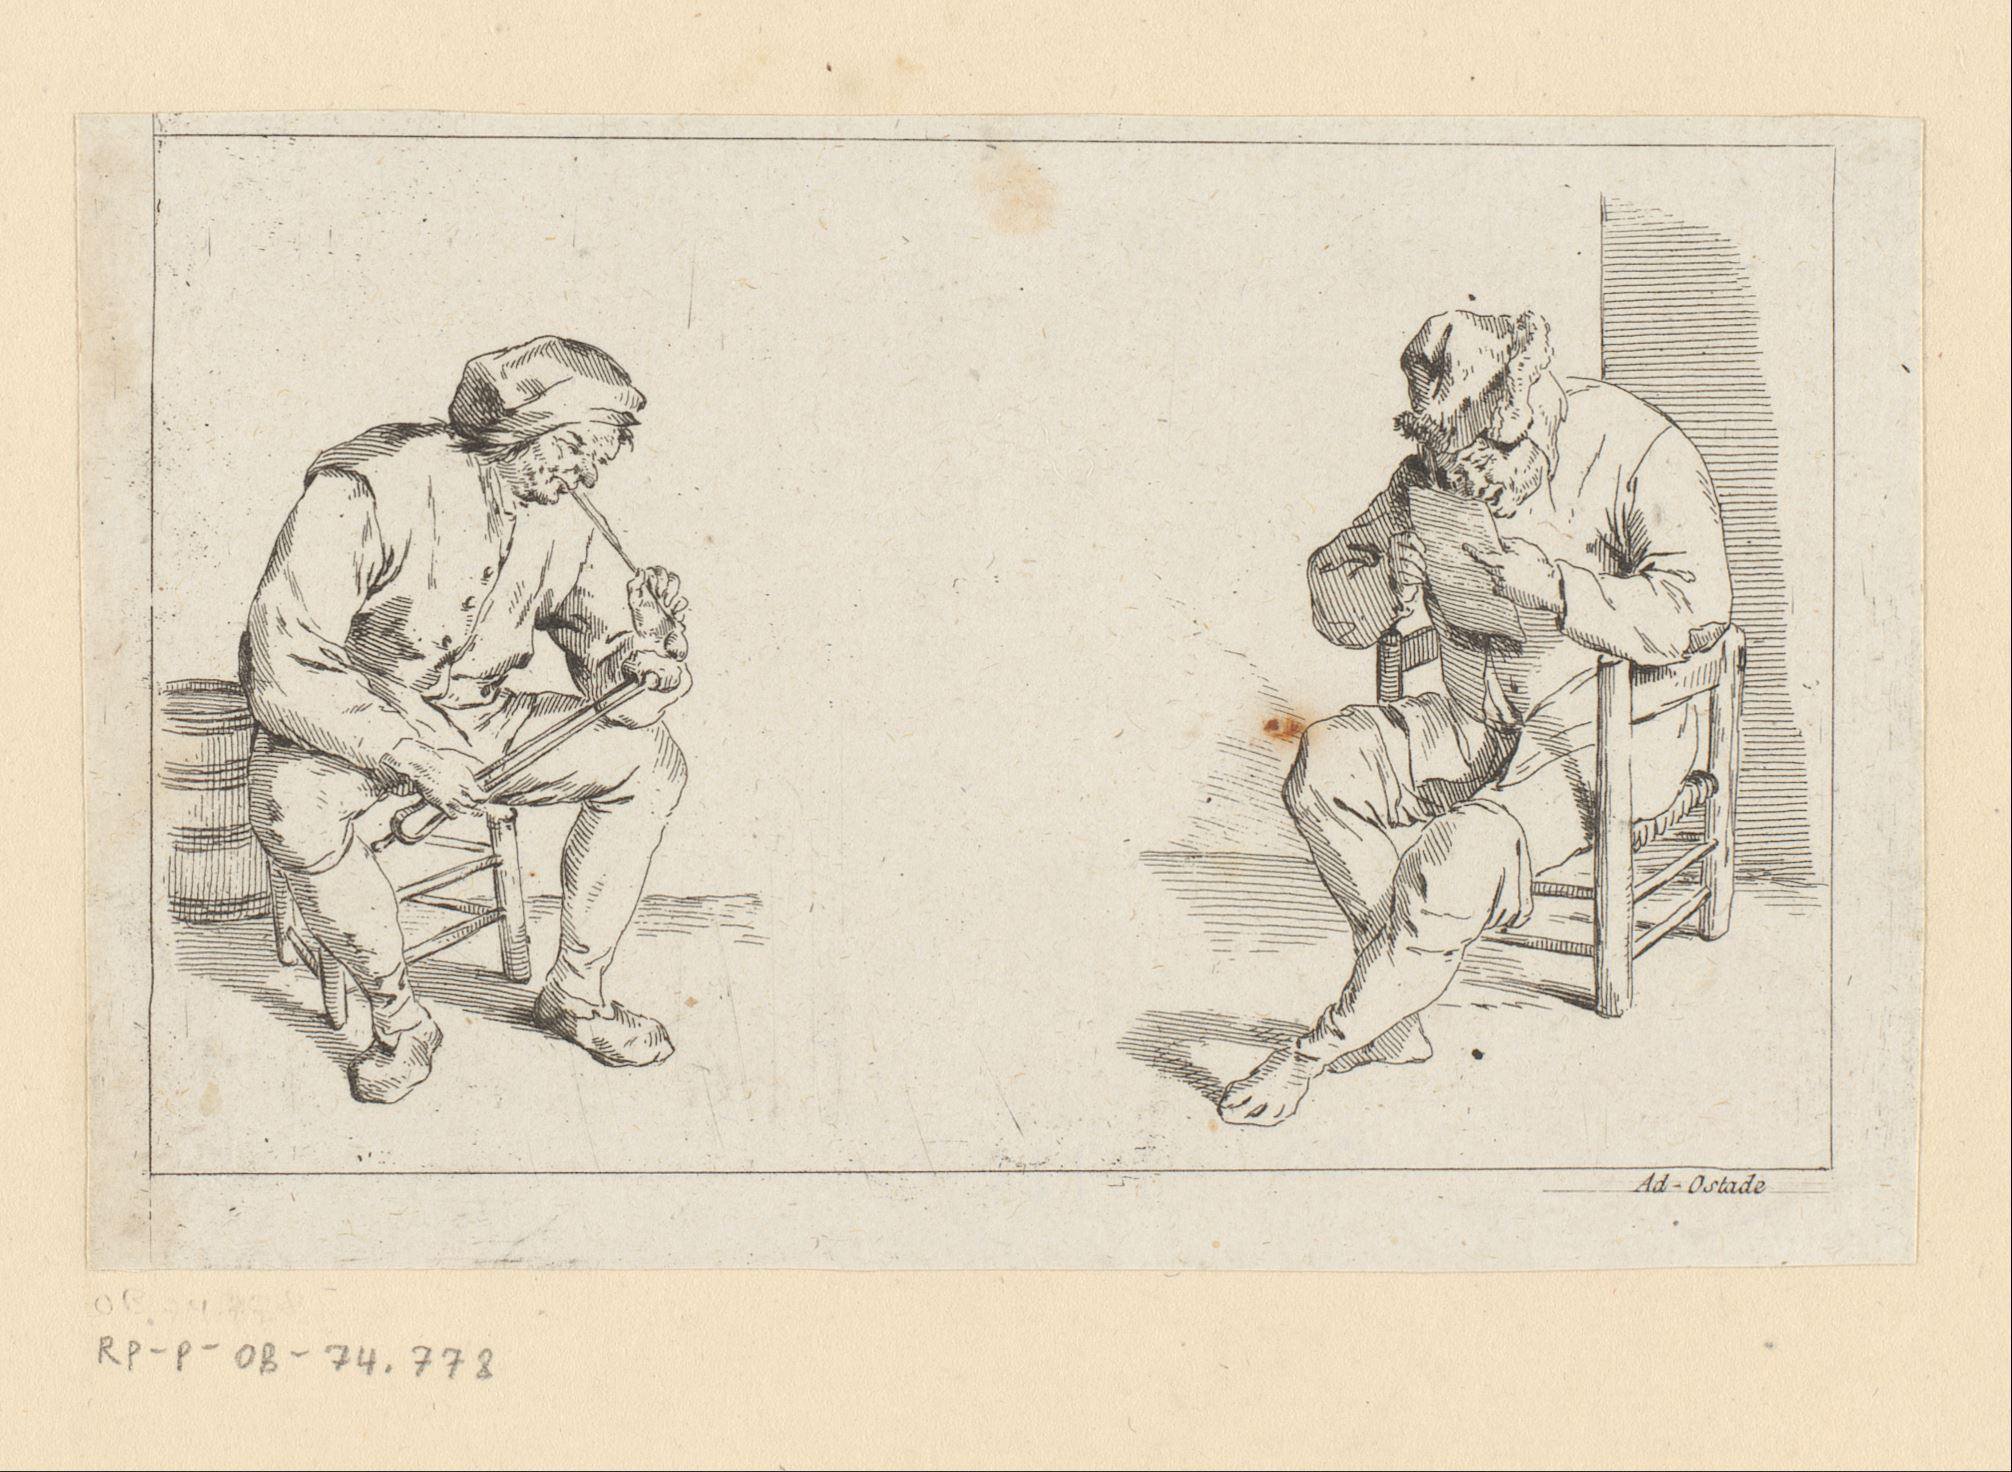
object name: print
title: Pijprokende man en een lezende man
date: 1700-1730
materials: paper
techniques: etching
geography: france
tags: reading, pipe ~ tobacco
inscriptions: collector's mark: Lugt 240